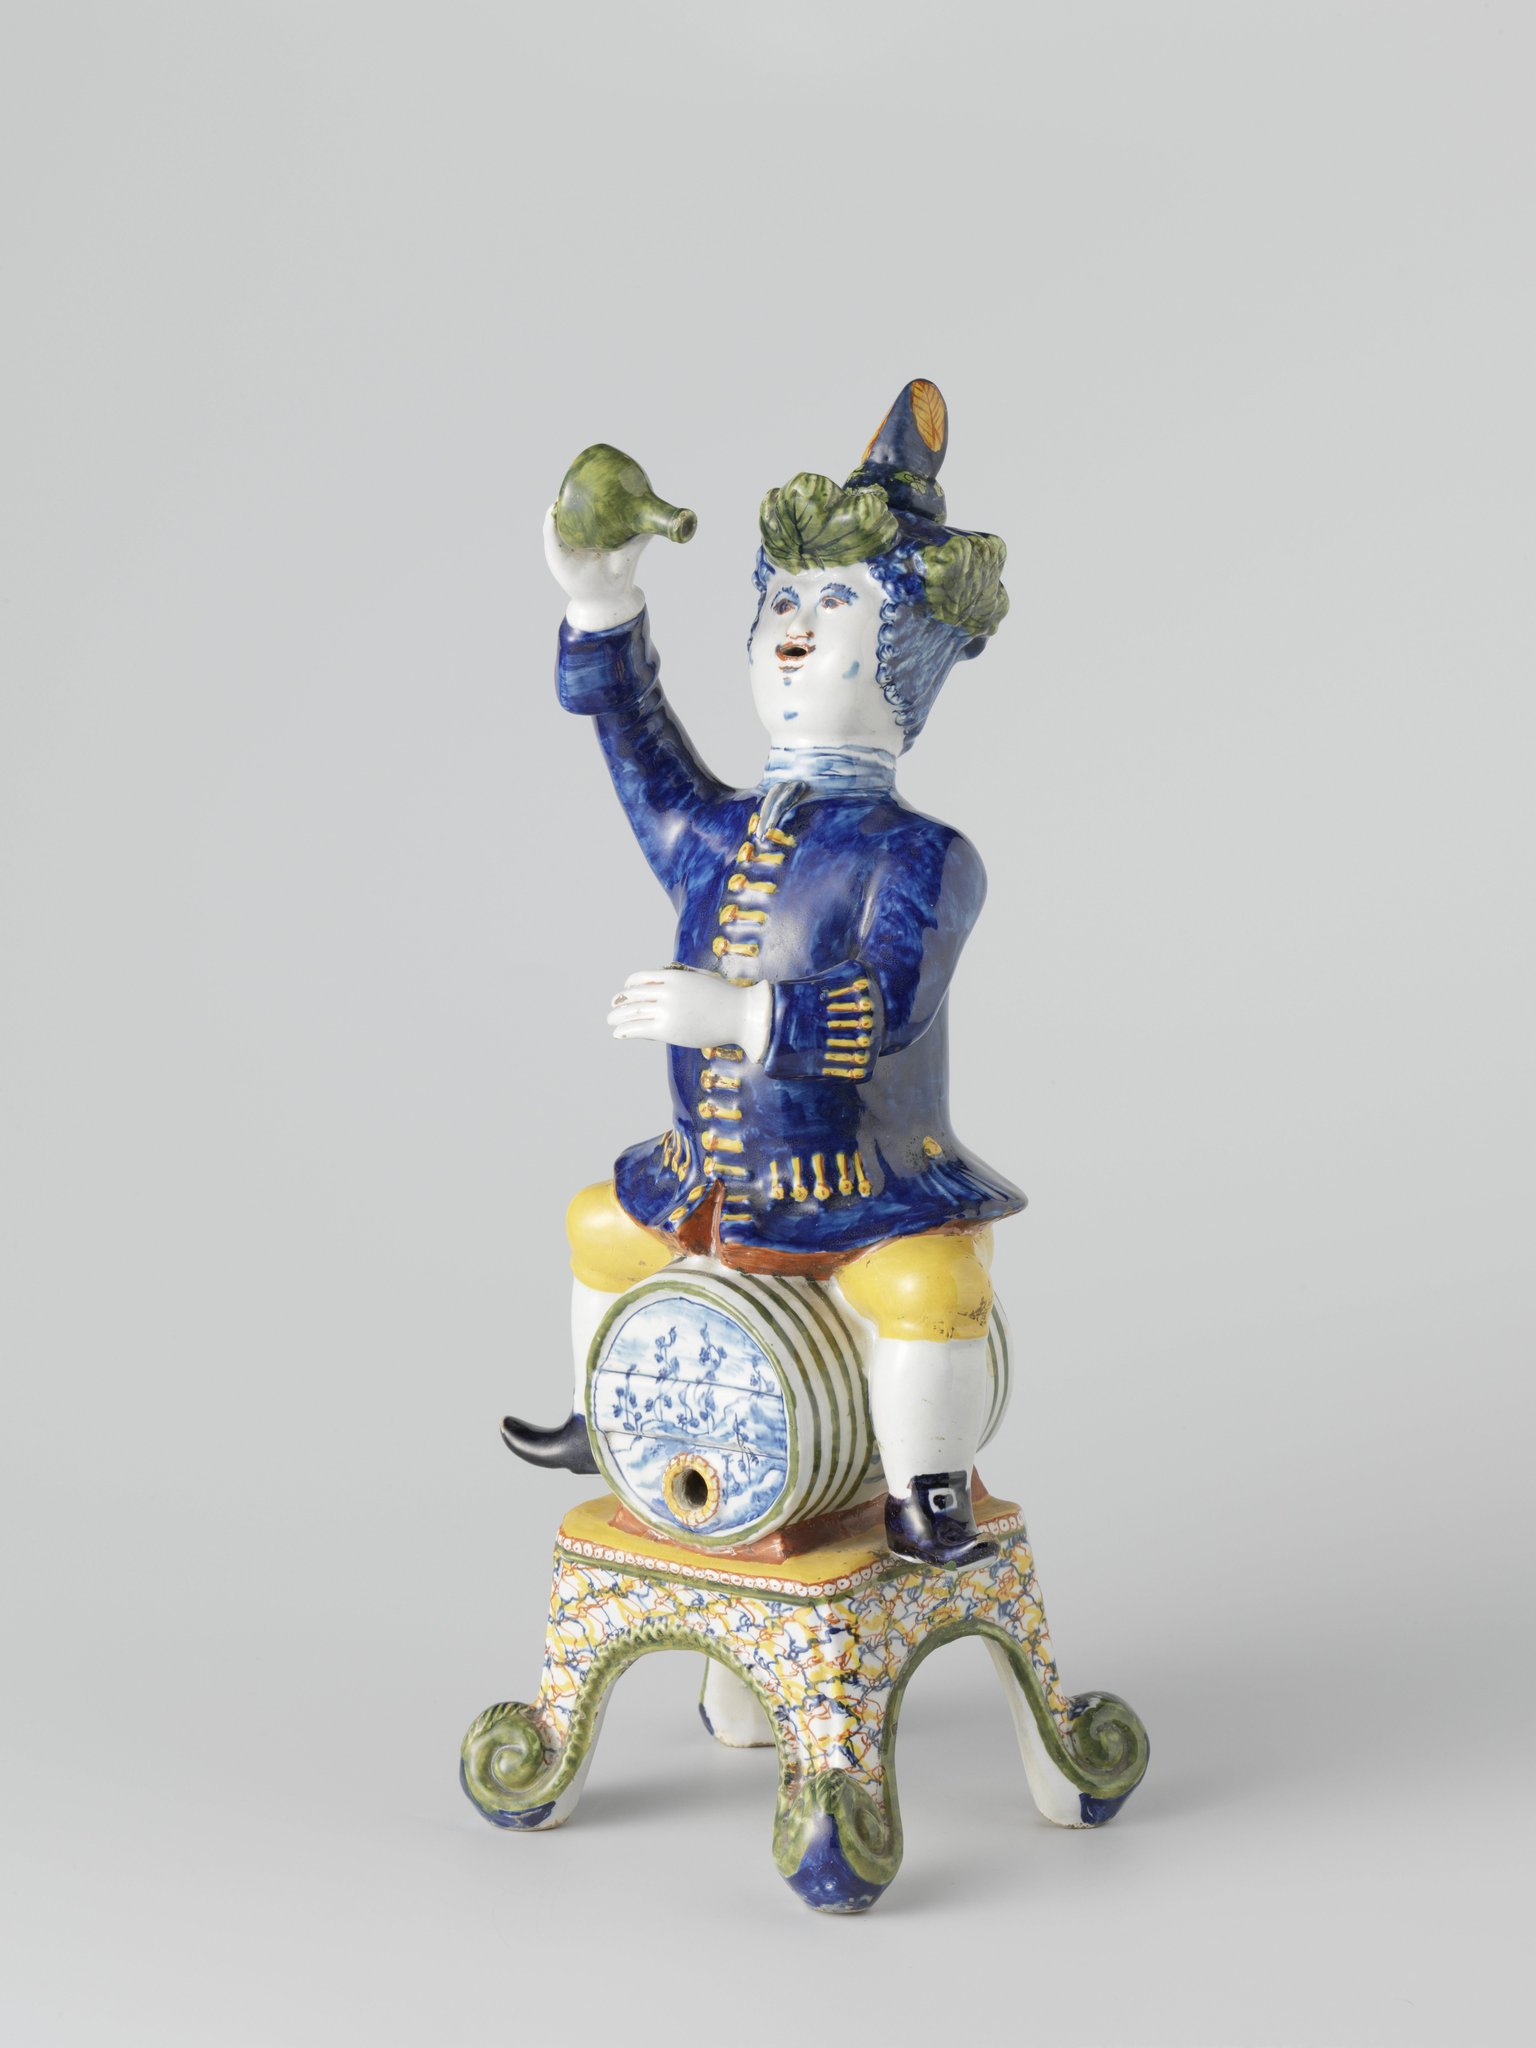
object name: decoratief object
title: Decoratief object: man met fles in hand, op ton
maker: Anonymous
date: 1760-1790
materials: earthenware, glaze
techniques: painted, polychromy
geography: delft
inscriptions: collector's mark: ‘collection JF Loudon’, inscription: ‘no 8’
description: Decoratief object van veelkleurig beschilderde faïence. Op een onderstel met vier poten ligt een ton. Op de ton zit een man met in zijn rechterhand een fles. De man heeft een blauwe jas.